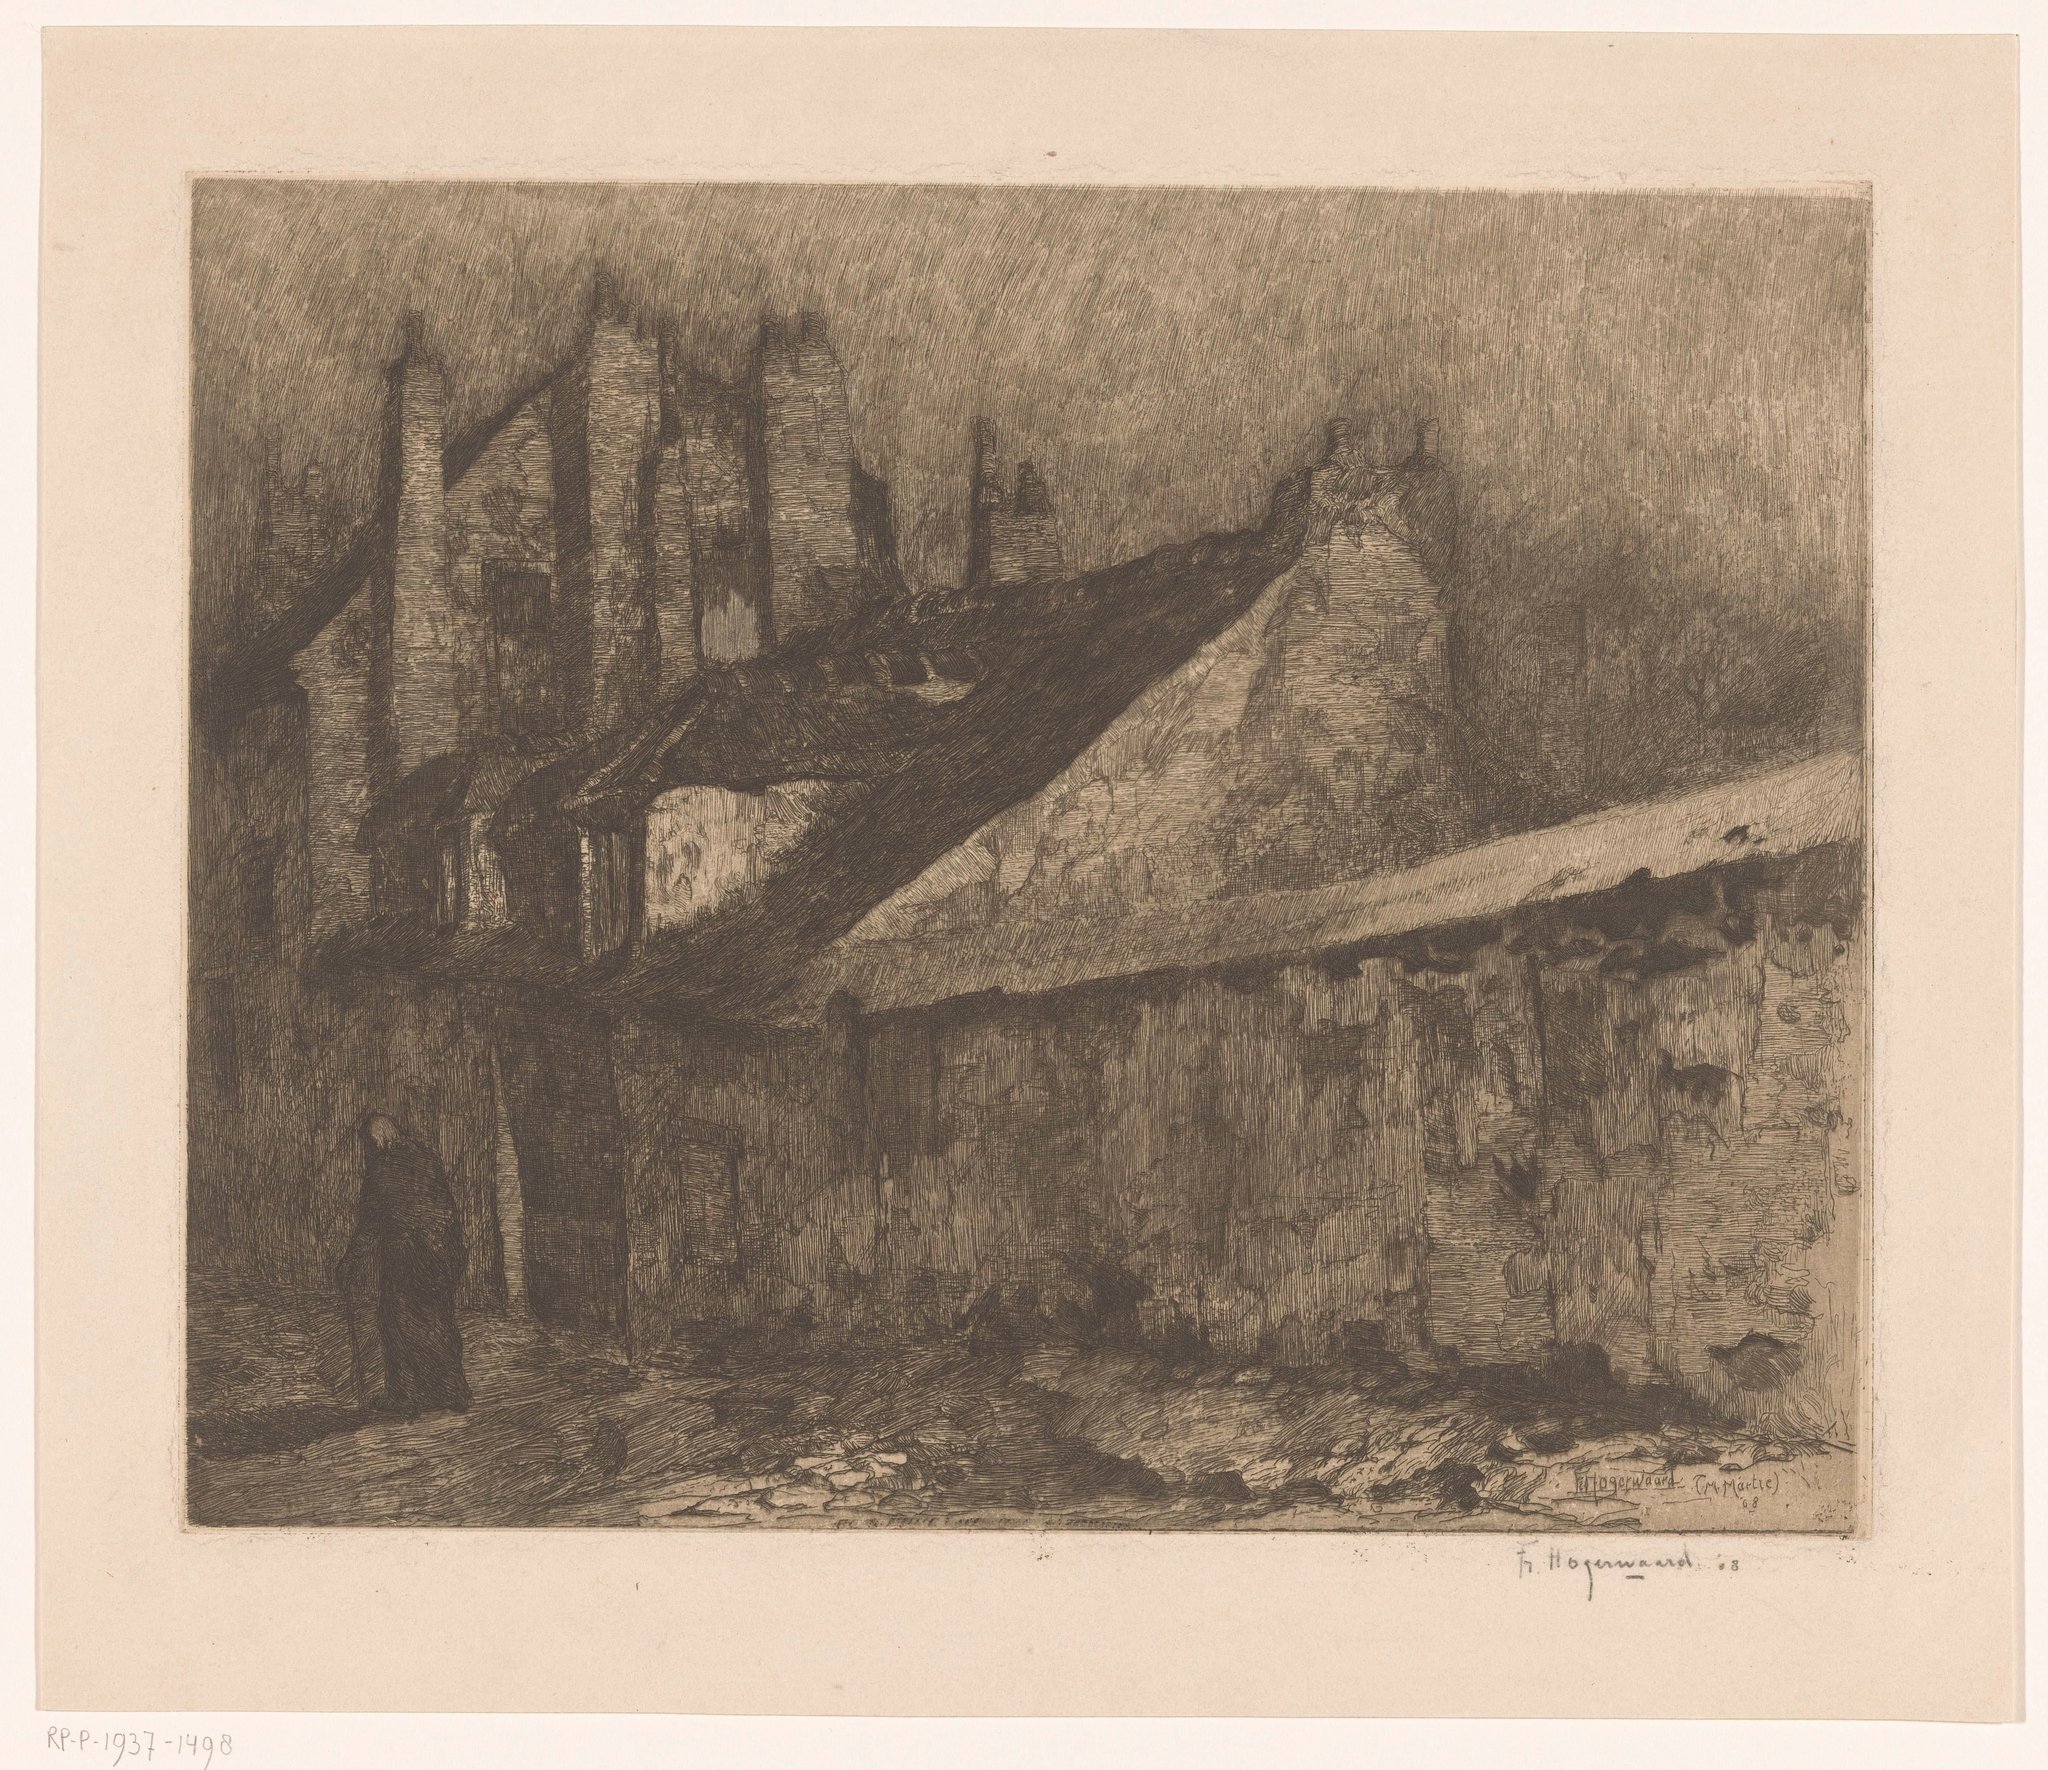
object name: print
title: Montmartre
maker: frans hogerwaard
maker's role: print maker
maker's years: 1882-1921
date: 1908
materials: paper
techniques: etching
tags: street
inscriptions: collector's mark: Lugt 2760, collector's mark: Lugt 2228